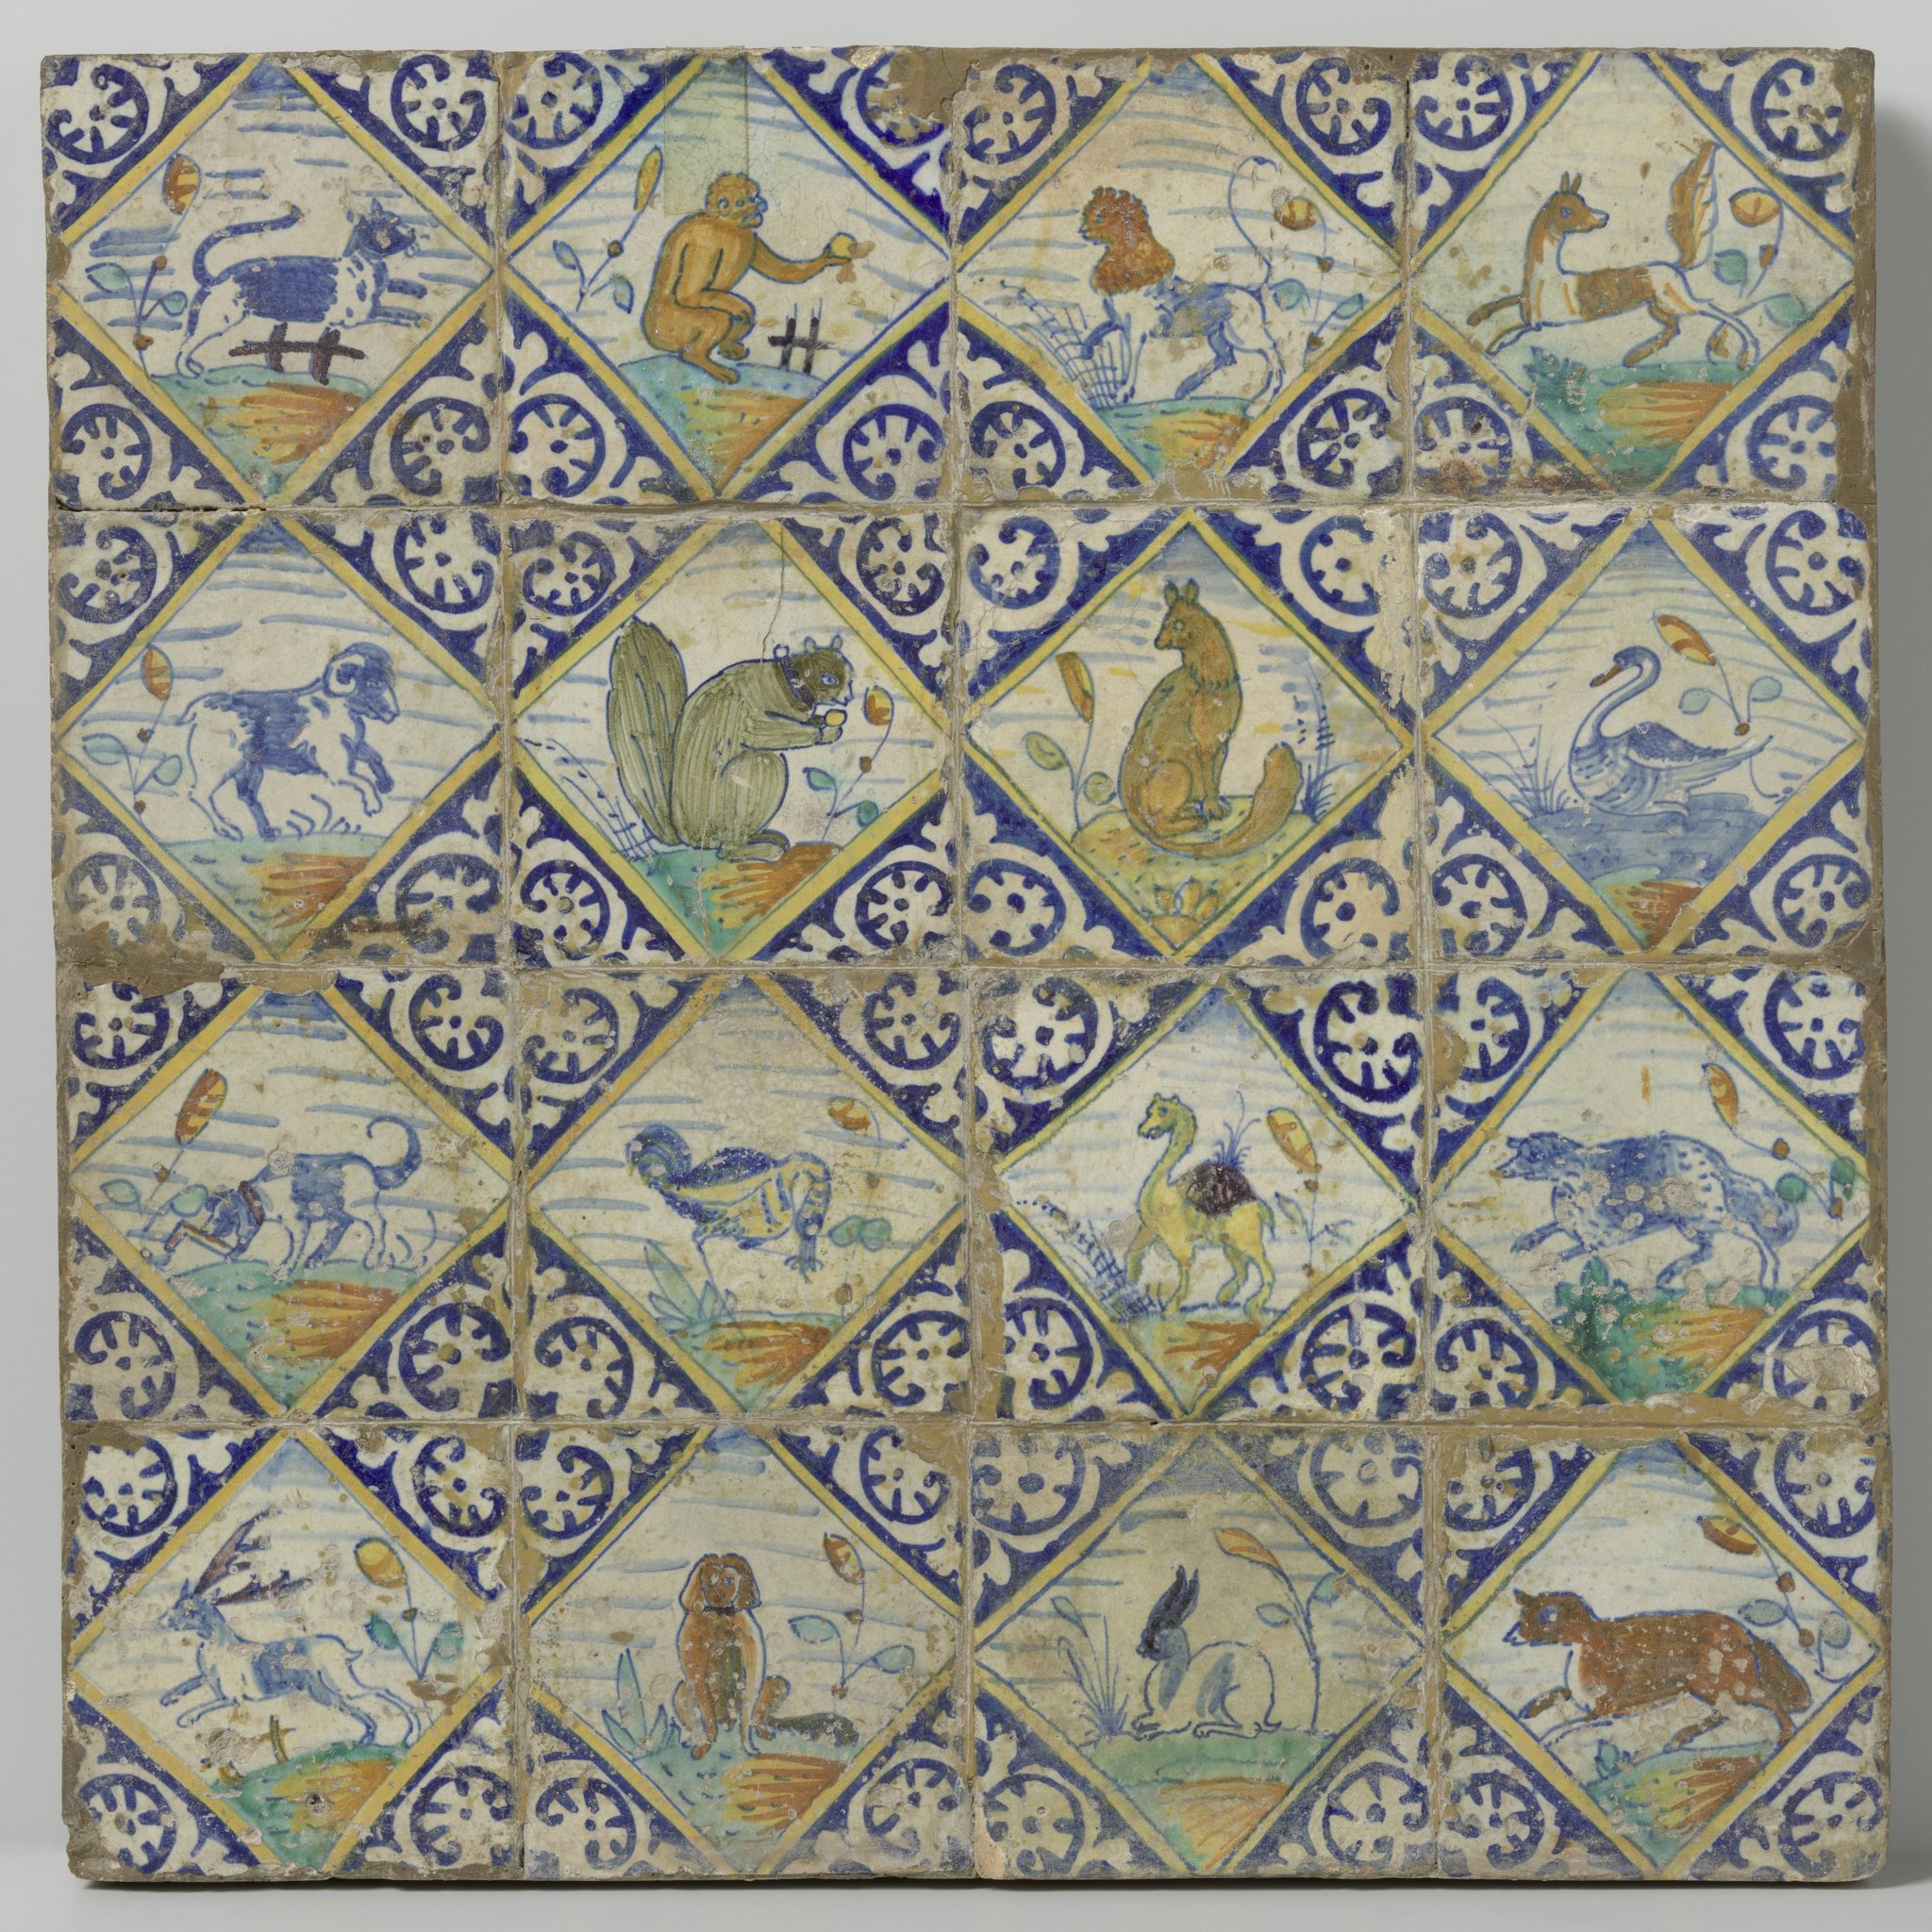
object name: tile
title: Veld van zestien tegels met dieren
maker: Anonymous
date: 1580-1625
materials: earthenware, glaze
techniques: maiolica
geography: netherlands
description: Veld van zestien tegels (4 x 4) elk met een veelkleurig (blauw, oranje, geel, groen, bruingroen en paars) geschilderd dier binnen een kwadraat. In de hoeken, vultechniek ornament.